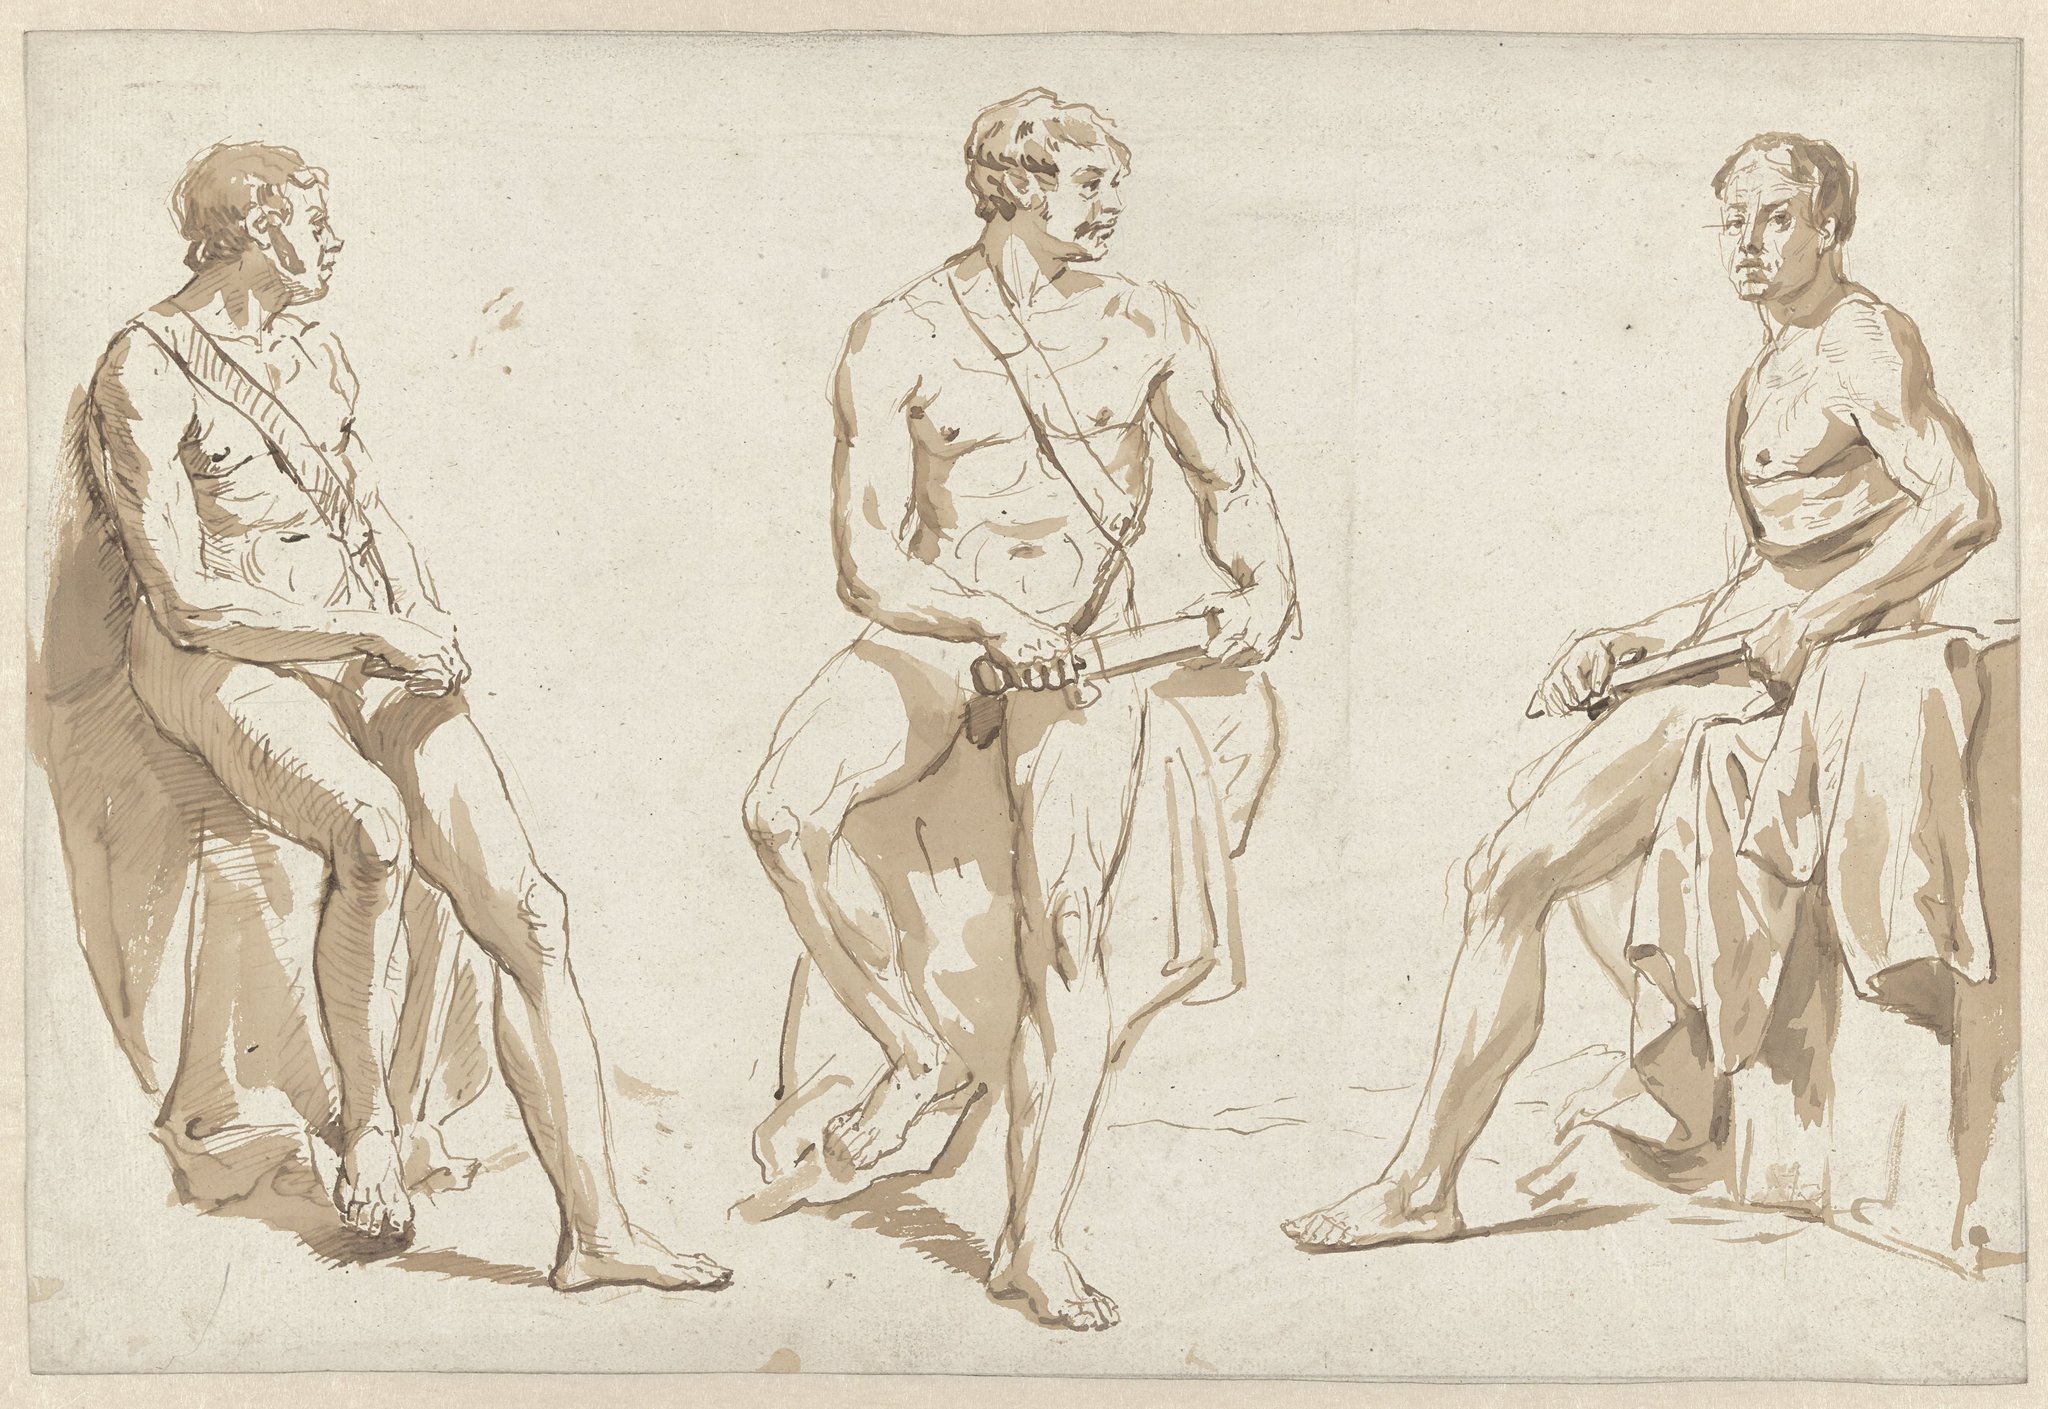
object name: drawing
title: Drie studies naar een mannelijk naaktmodel, zittend met een zwaard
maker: christiaan van geelen jr.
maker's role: draughtsman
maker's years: 1794-1826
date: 1804-1826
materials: ink, paper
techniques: brush, pen